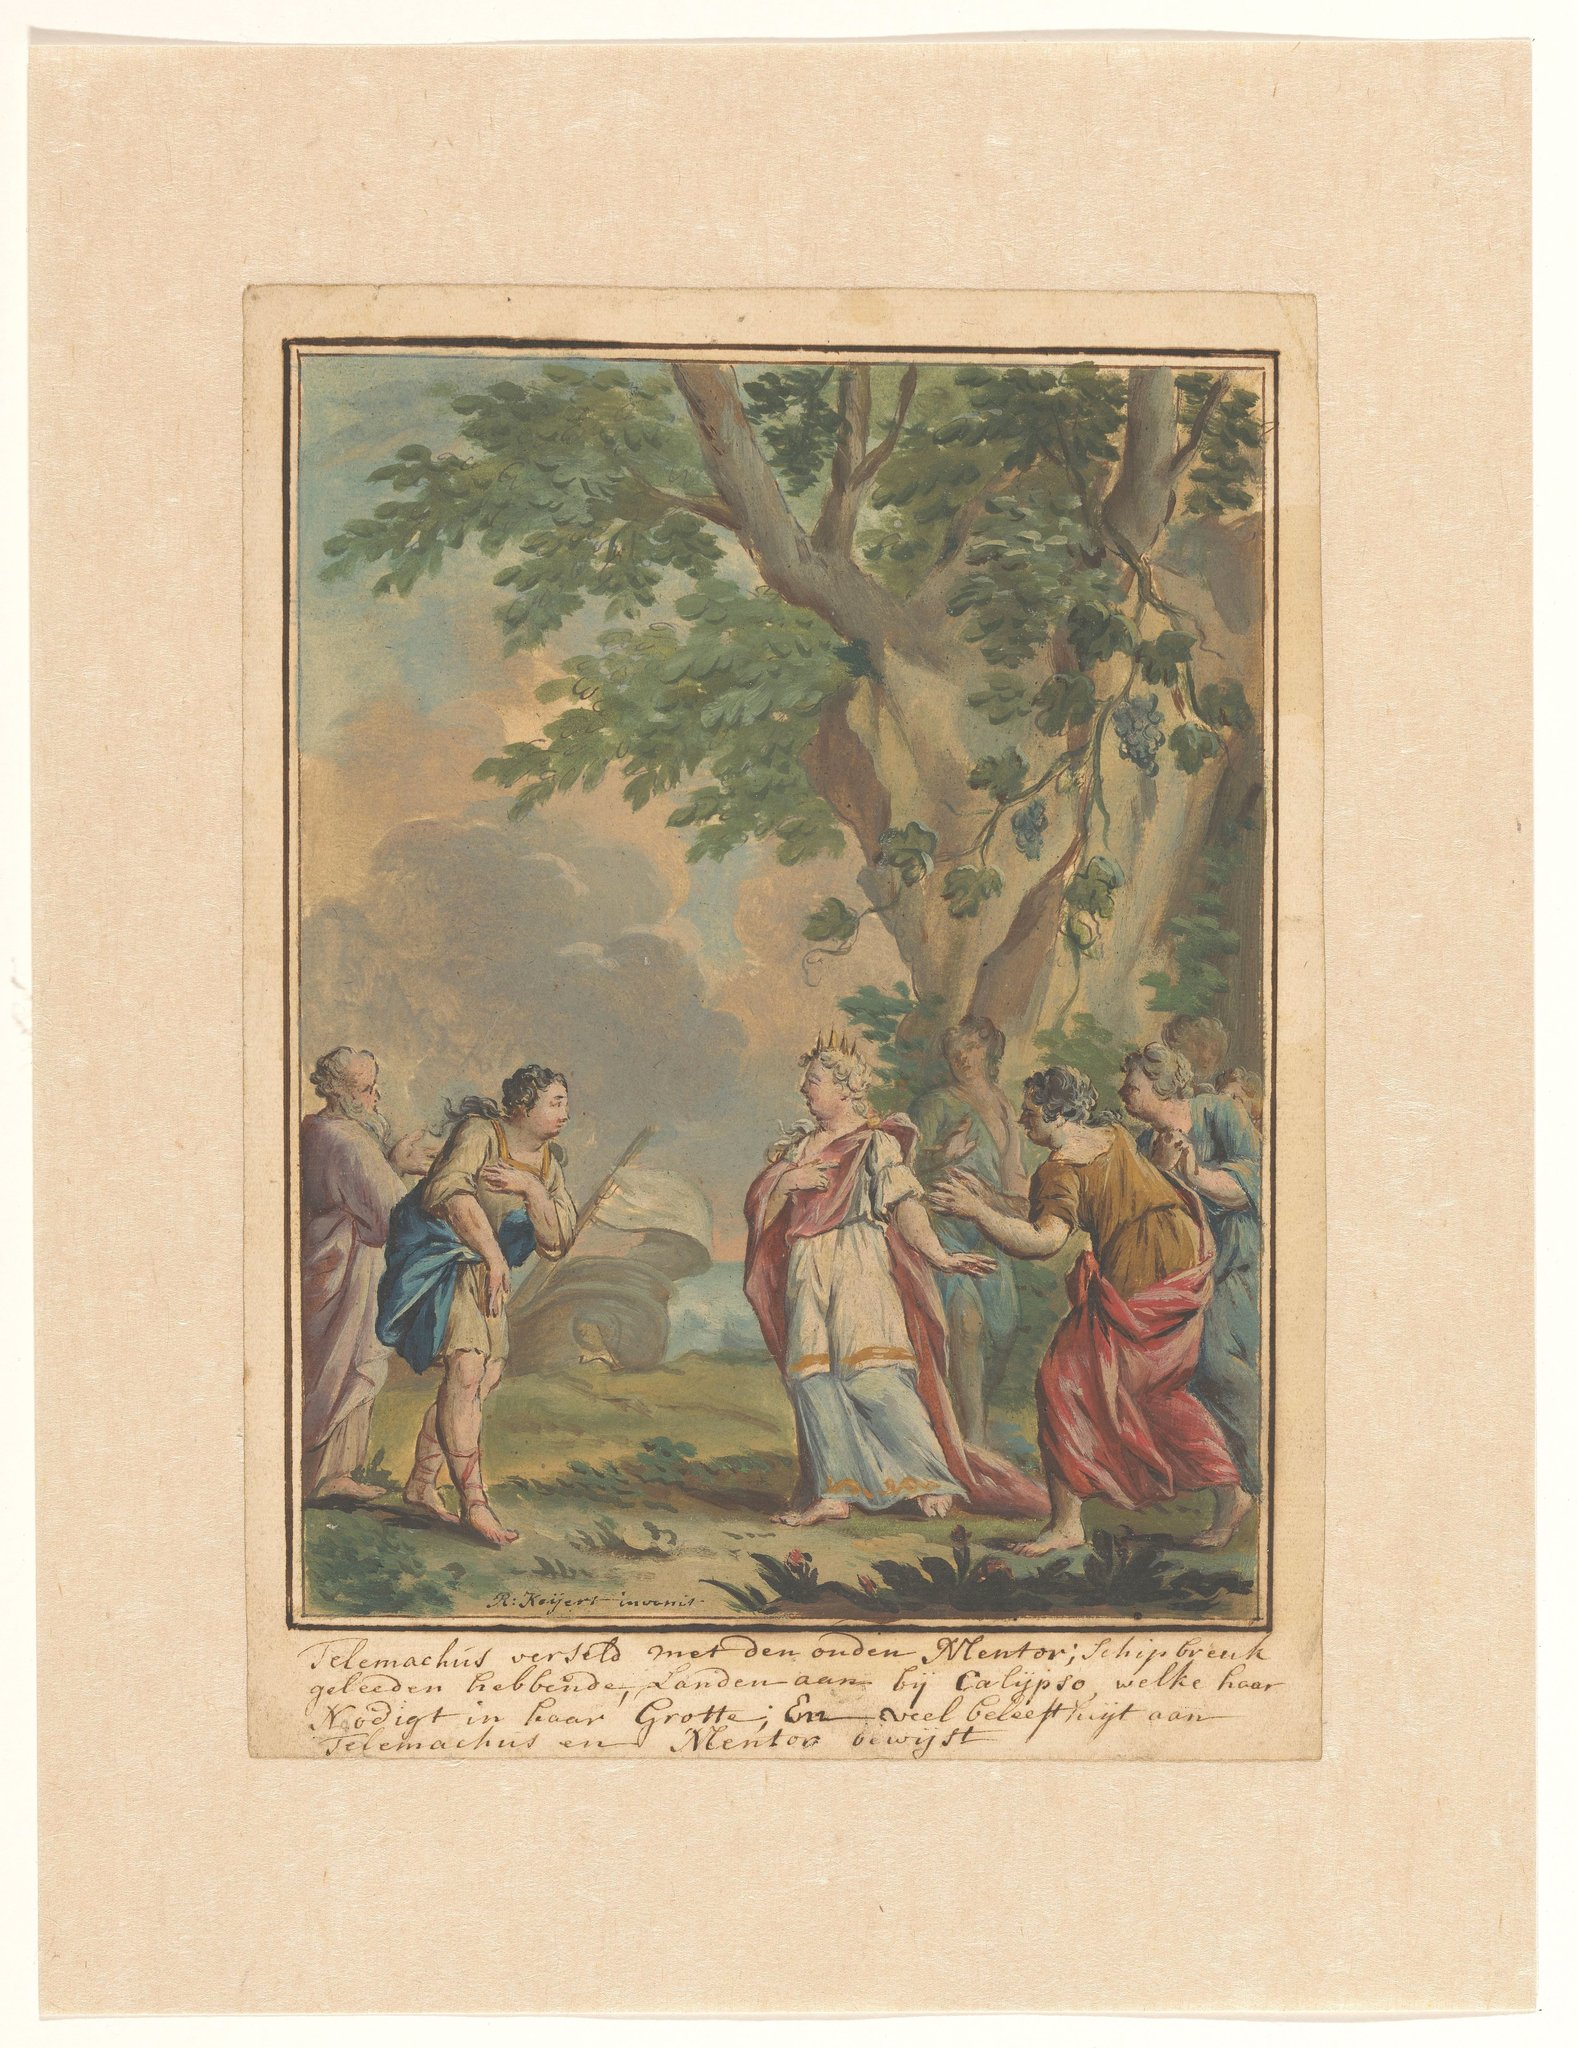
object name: design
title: Telemachus-reeks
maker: rienk keyert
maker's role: draughtsman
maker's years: 1709-1775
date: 1719-1775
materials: ink, paper, watercolor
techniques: brush, pen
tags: (story of) telemachus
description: Telemachus en Mentor komen aan bij de nimf Calypso. Onderaan in de marge beschrijving van de voorstelling. Ontwerp voor een behangschildering.